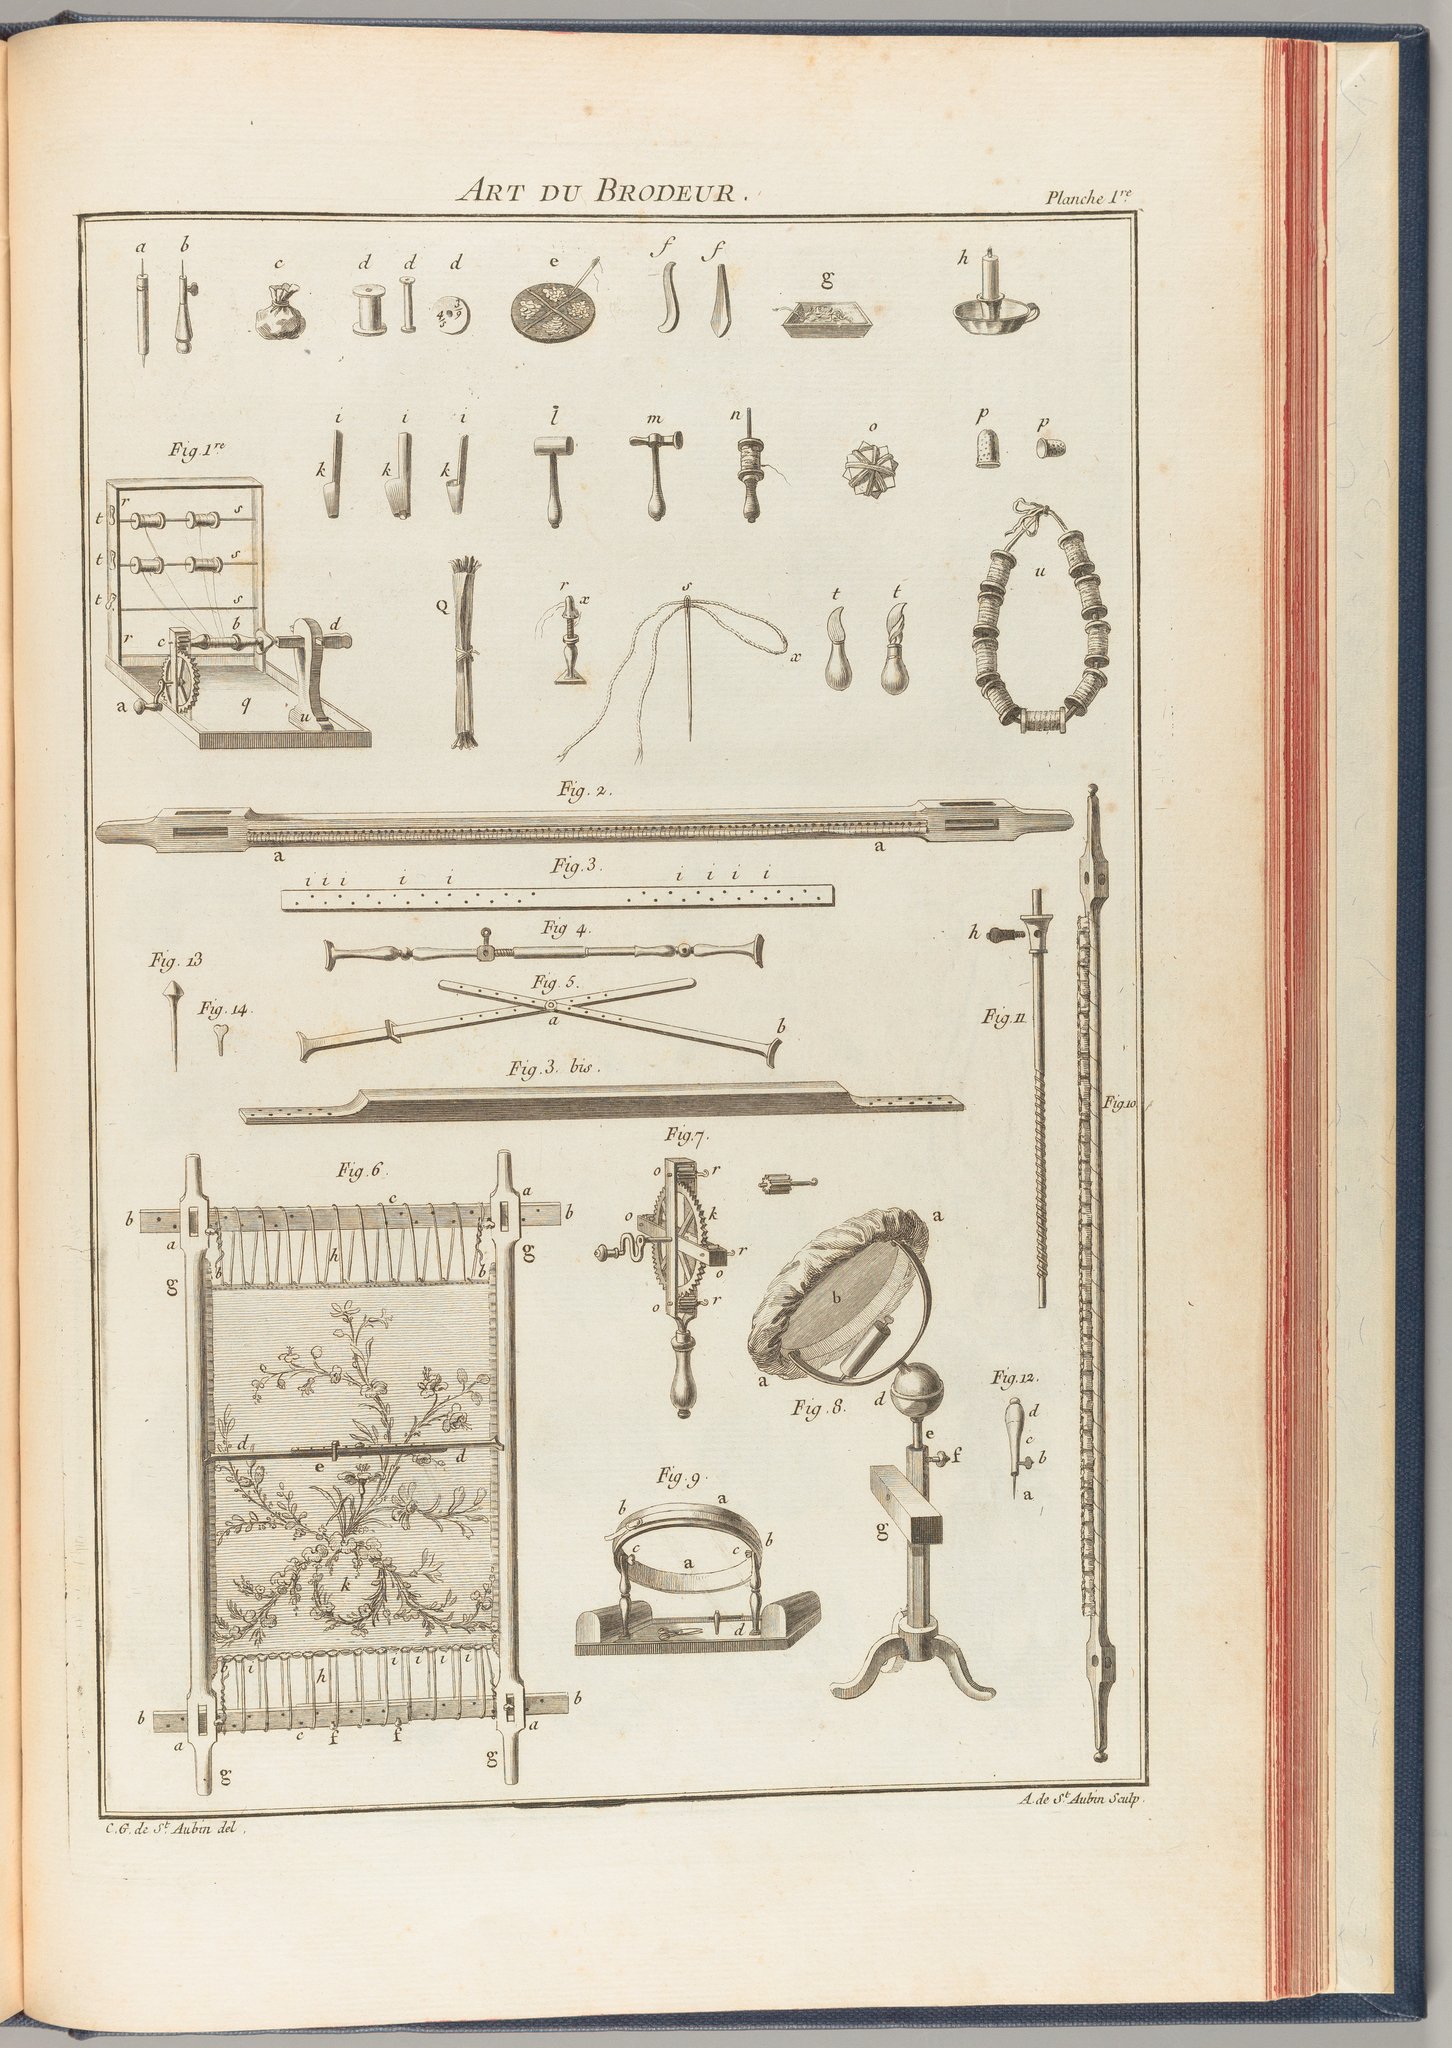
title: L'Art du brodeur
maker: charles germain de saint-aubin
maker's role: author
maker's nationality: french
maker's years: 1721-1786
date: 1770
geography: france